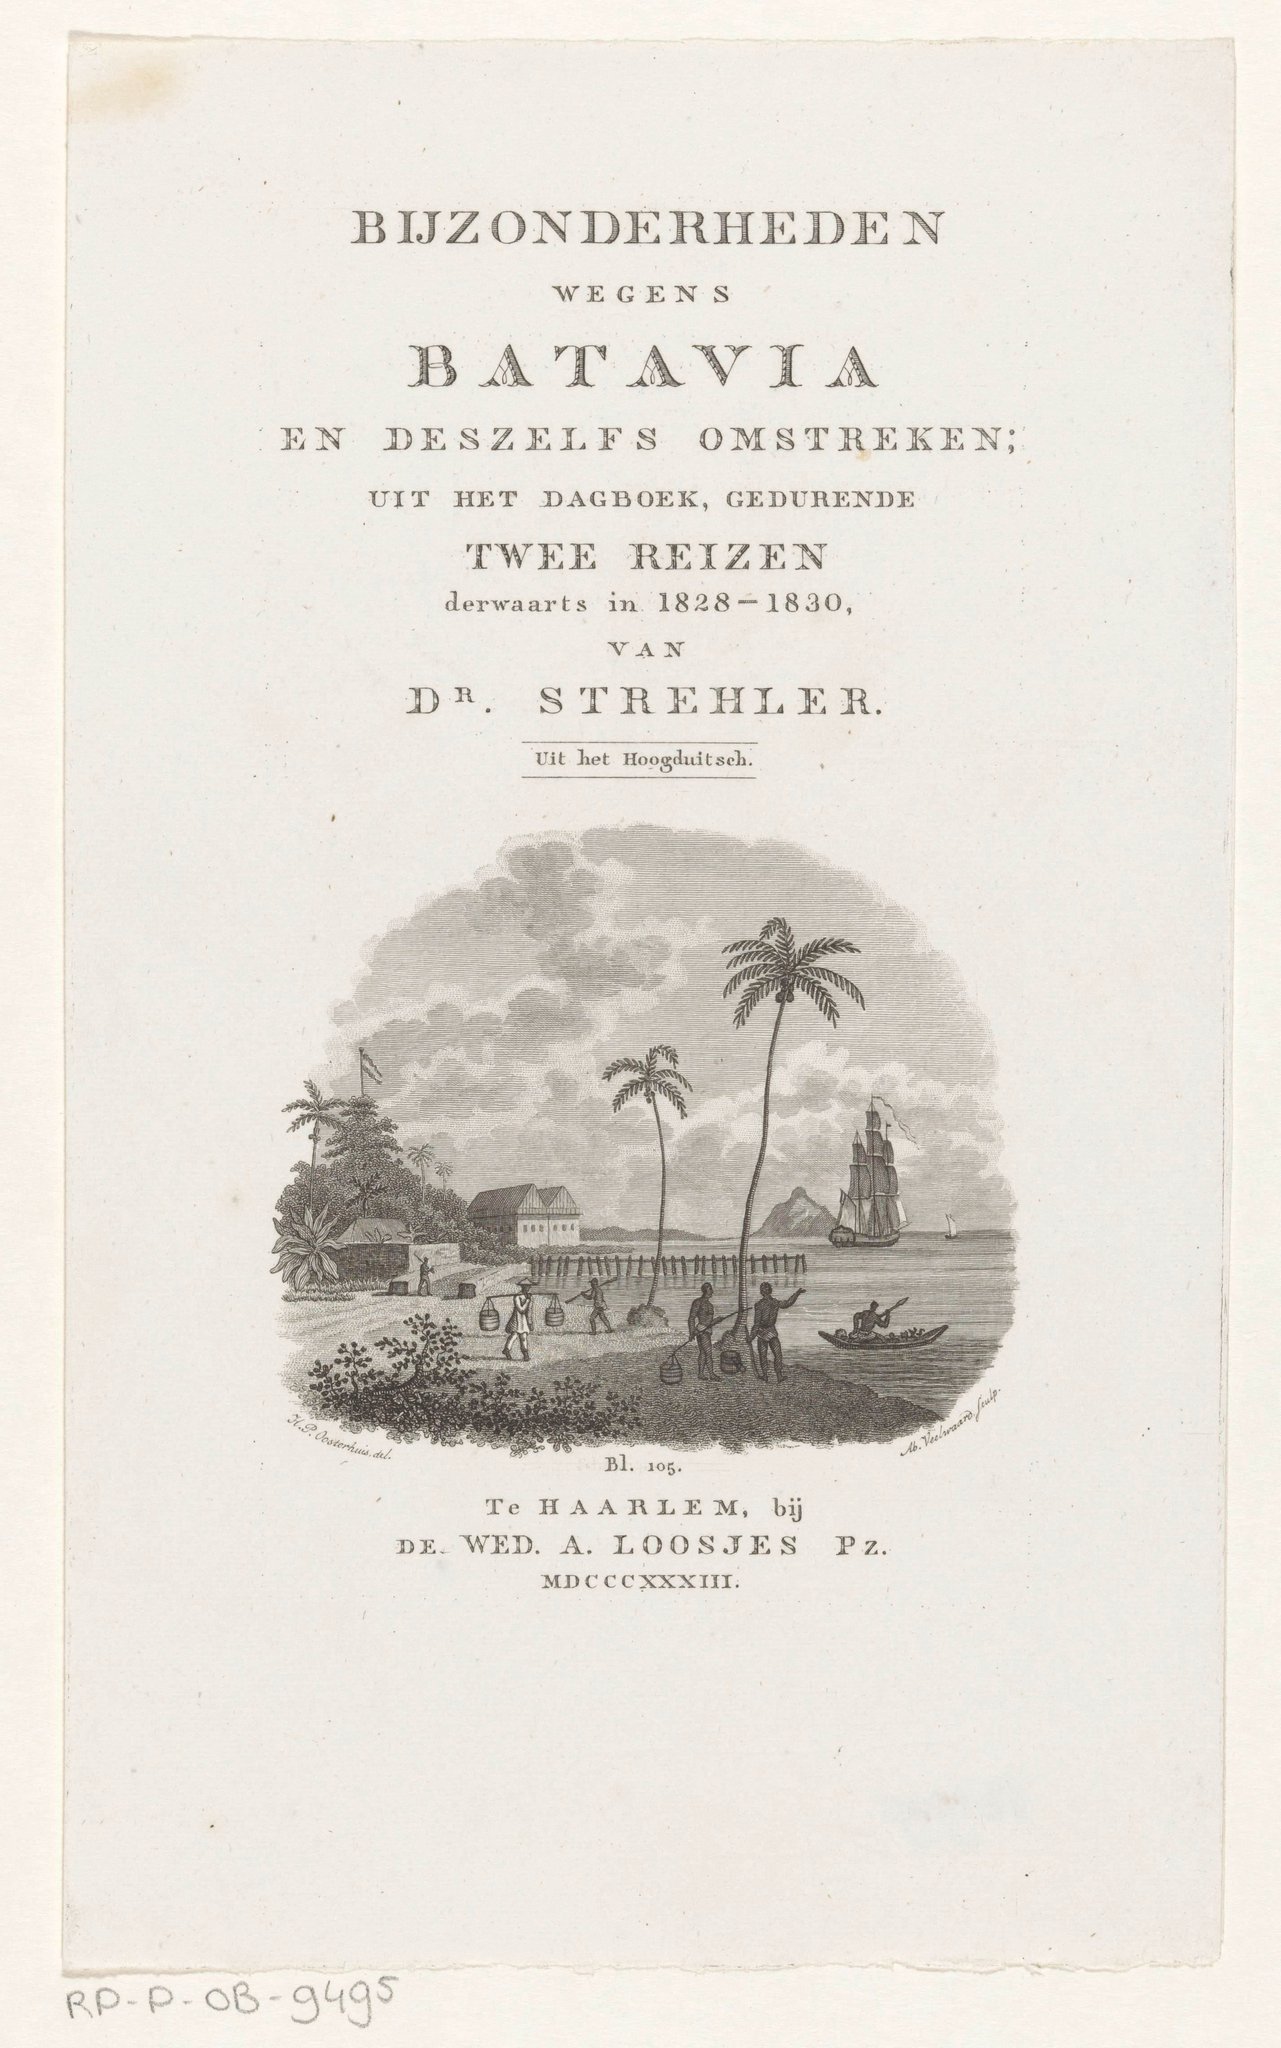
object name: titelblad, titelpagina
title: Straat van Soenda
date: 1833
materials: paper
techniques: engraving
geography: haarlem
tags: sea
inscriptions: collector's mark: Lugt 2228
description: Titelpagina voor: Strehler, Joseph. Bijzonderheden wegens Batavia en deszelfs omstreken; uit het dagboek, gedurende twee reizen derwaarts in 1828-1830. Haarlem: Loosjes Pz., weduwe Adriaan, 1833.